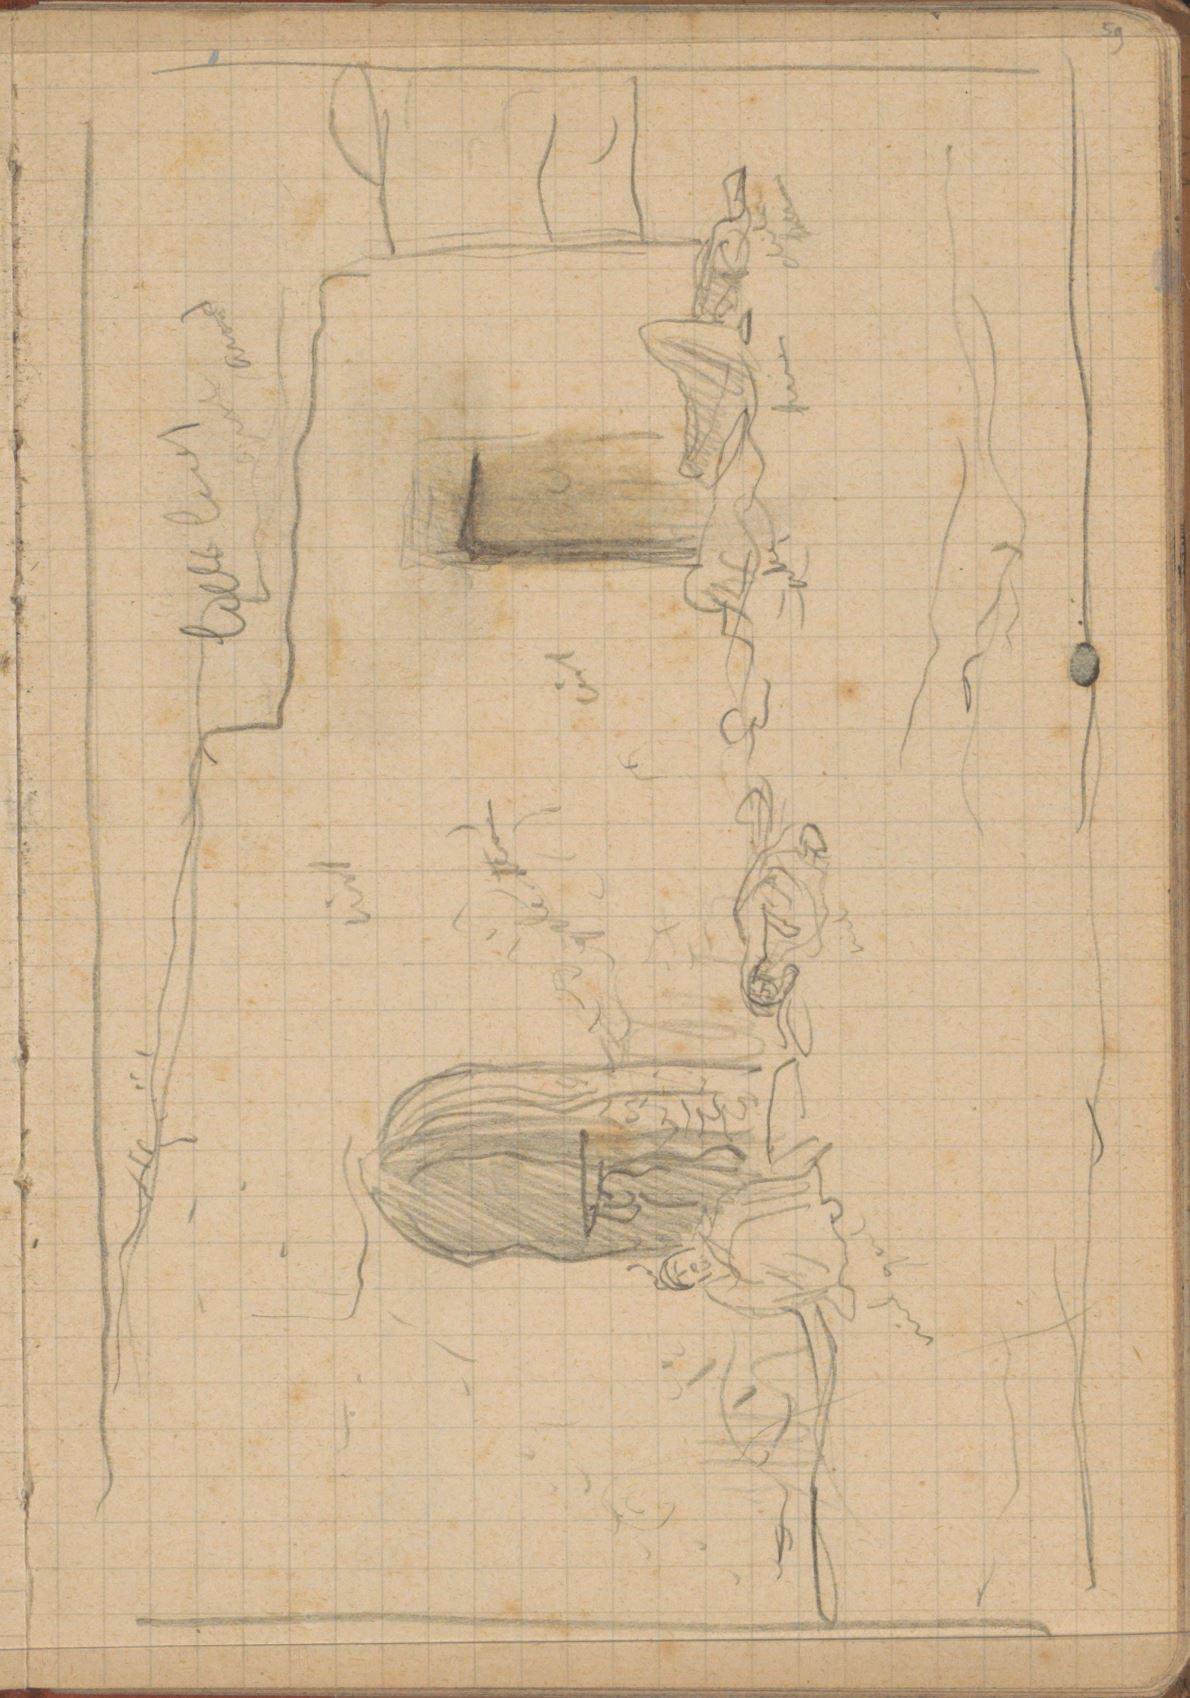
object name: sketchbook leaf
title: Liggende en zittende figuren op een binnenplaats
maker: marius bauer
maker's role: draughtsman, print maker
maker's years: 1867-1932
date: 1909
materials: pencil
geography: tunis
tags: sitting figure, courtyard, lying figure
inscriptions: kleurnotitie, handgeschreven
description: Pagina 59 uit een schetsboek met 67 bladen.